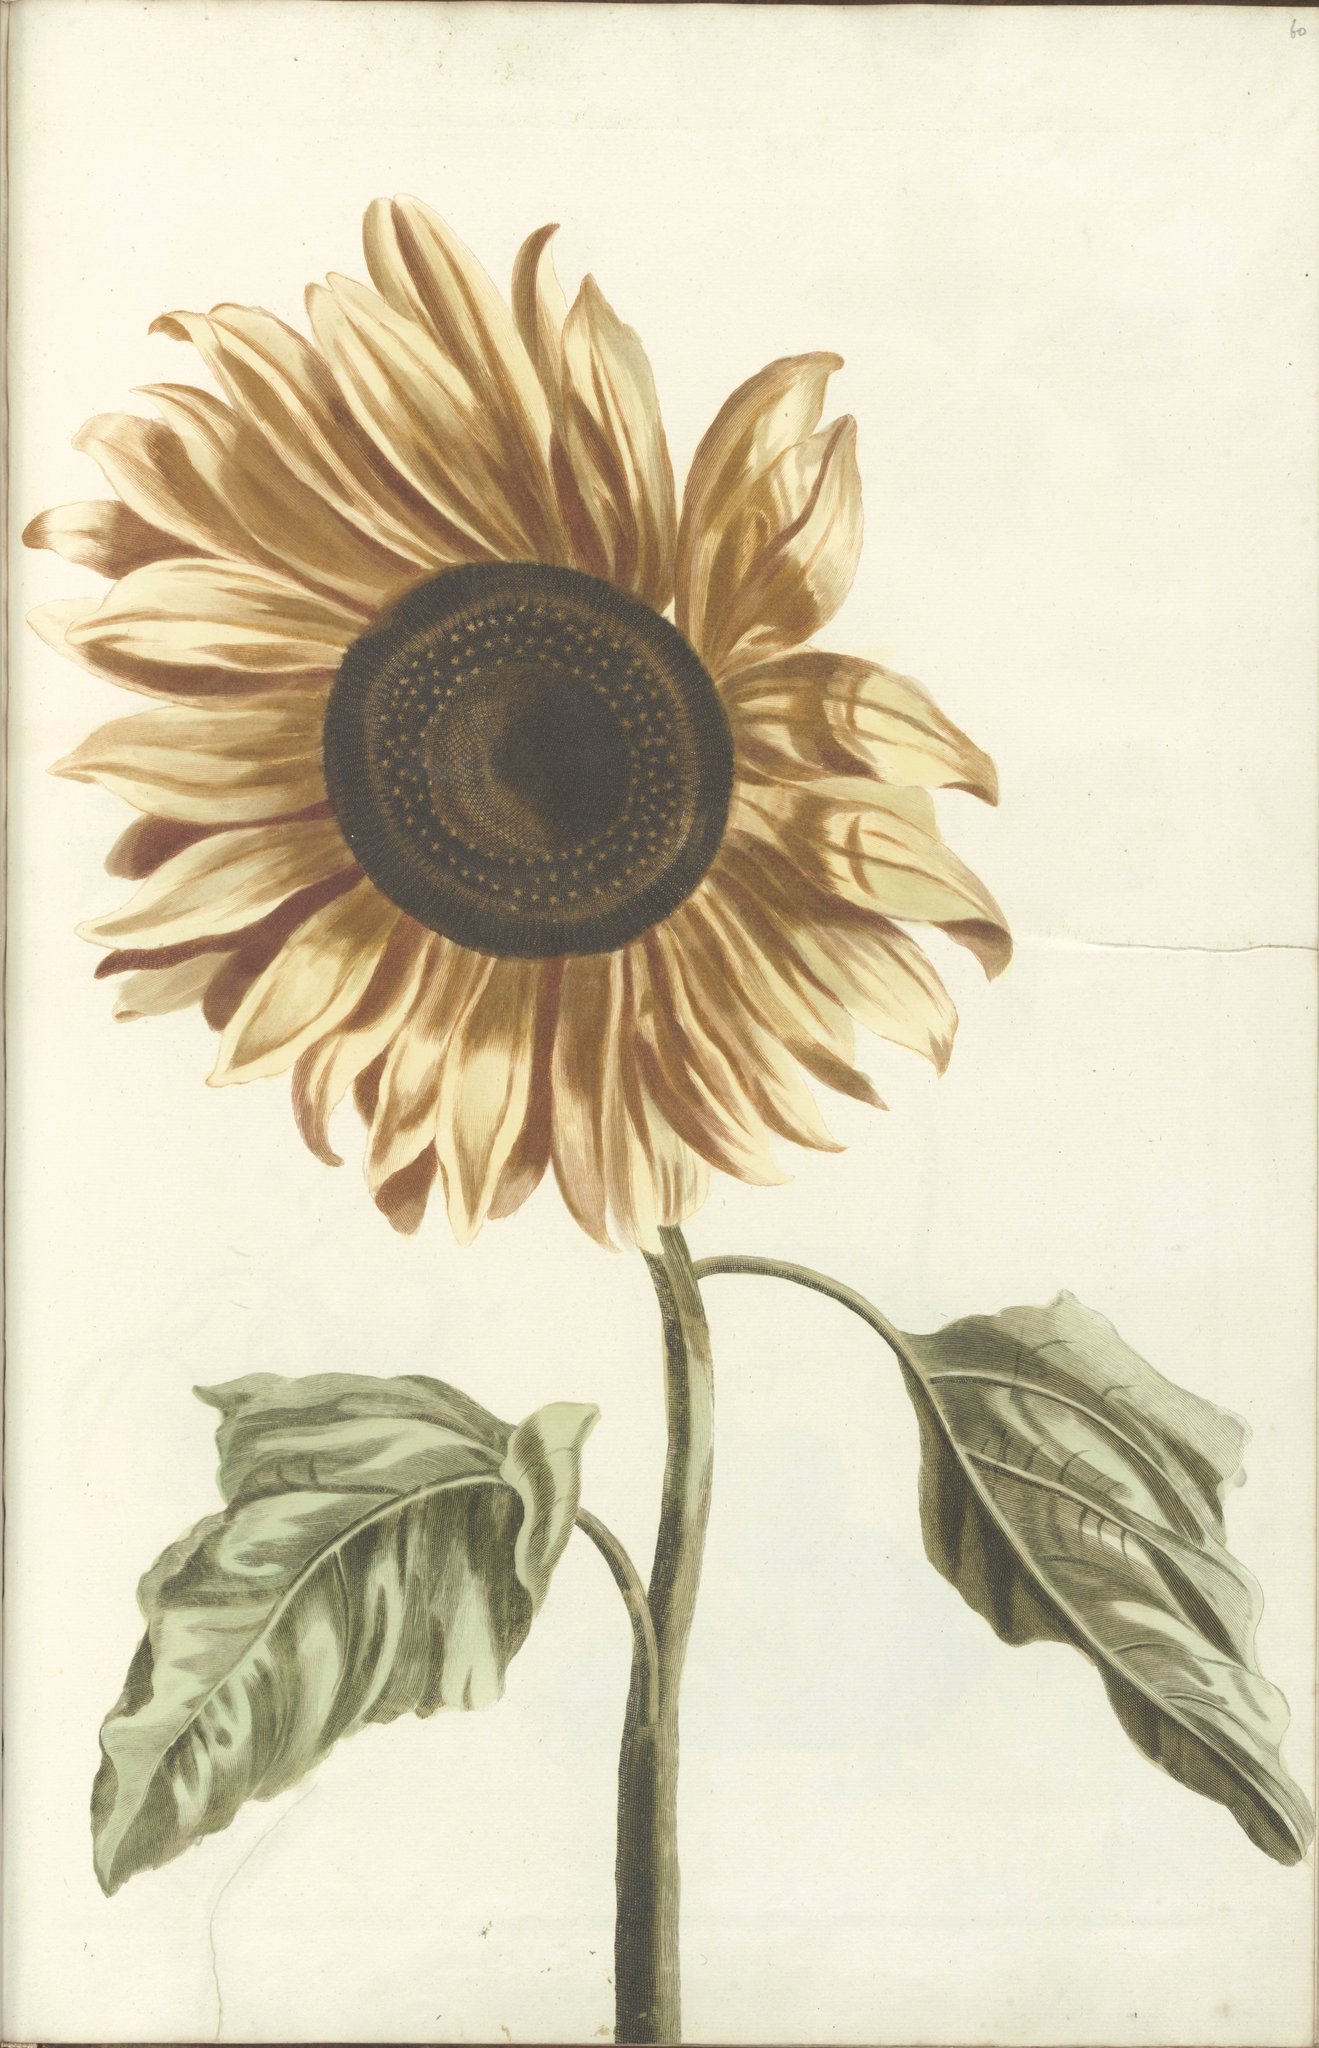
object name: album leaf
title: Zonnebloem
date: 1688-1698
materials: paper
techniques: printing, engraving, hand coloring, lithography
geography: netherlands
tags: flowers: sunflower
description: Deze prent maakt deel uit van een album.